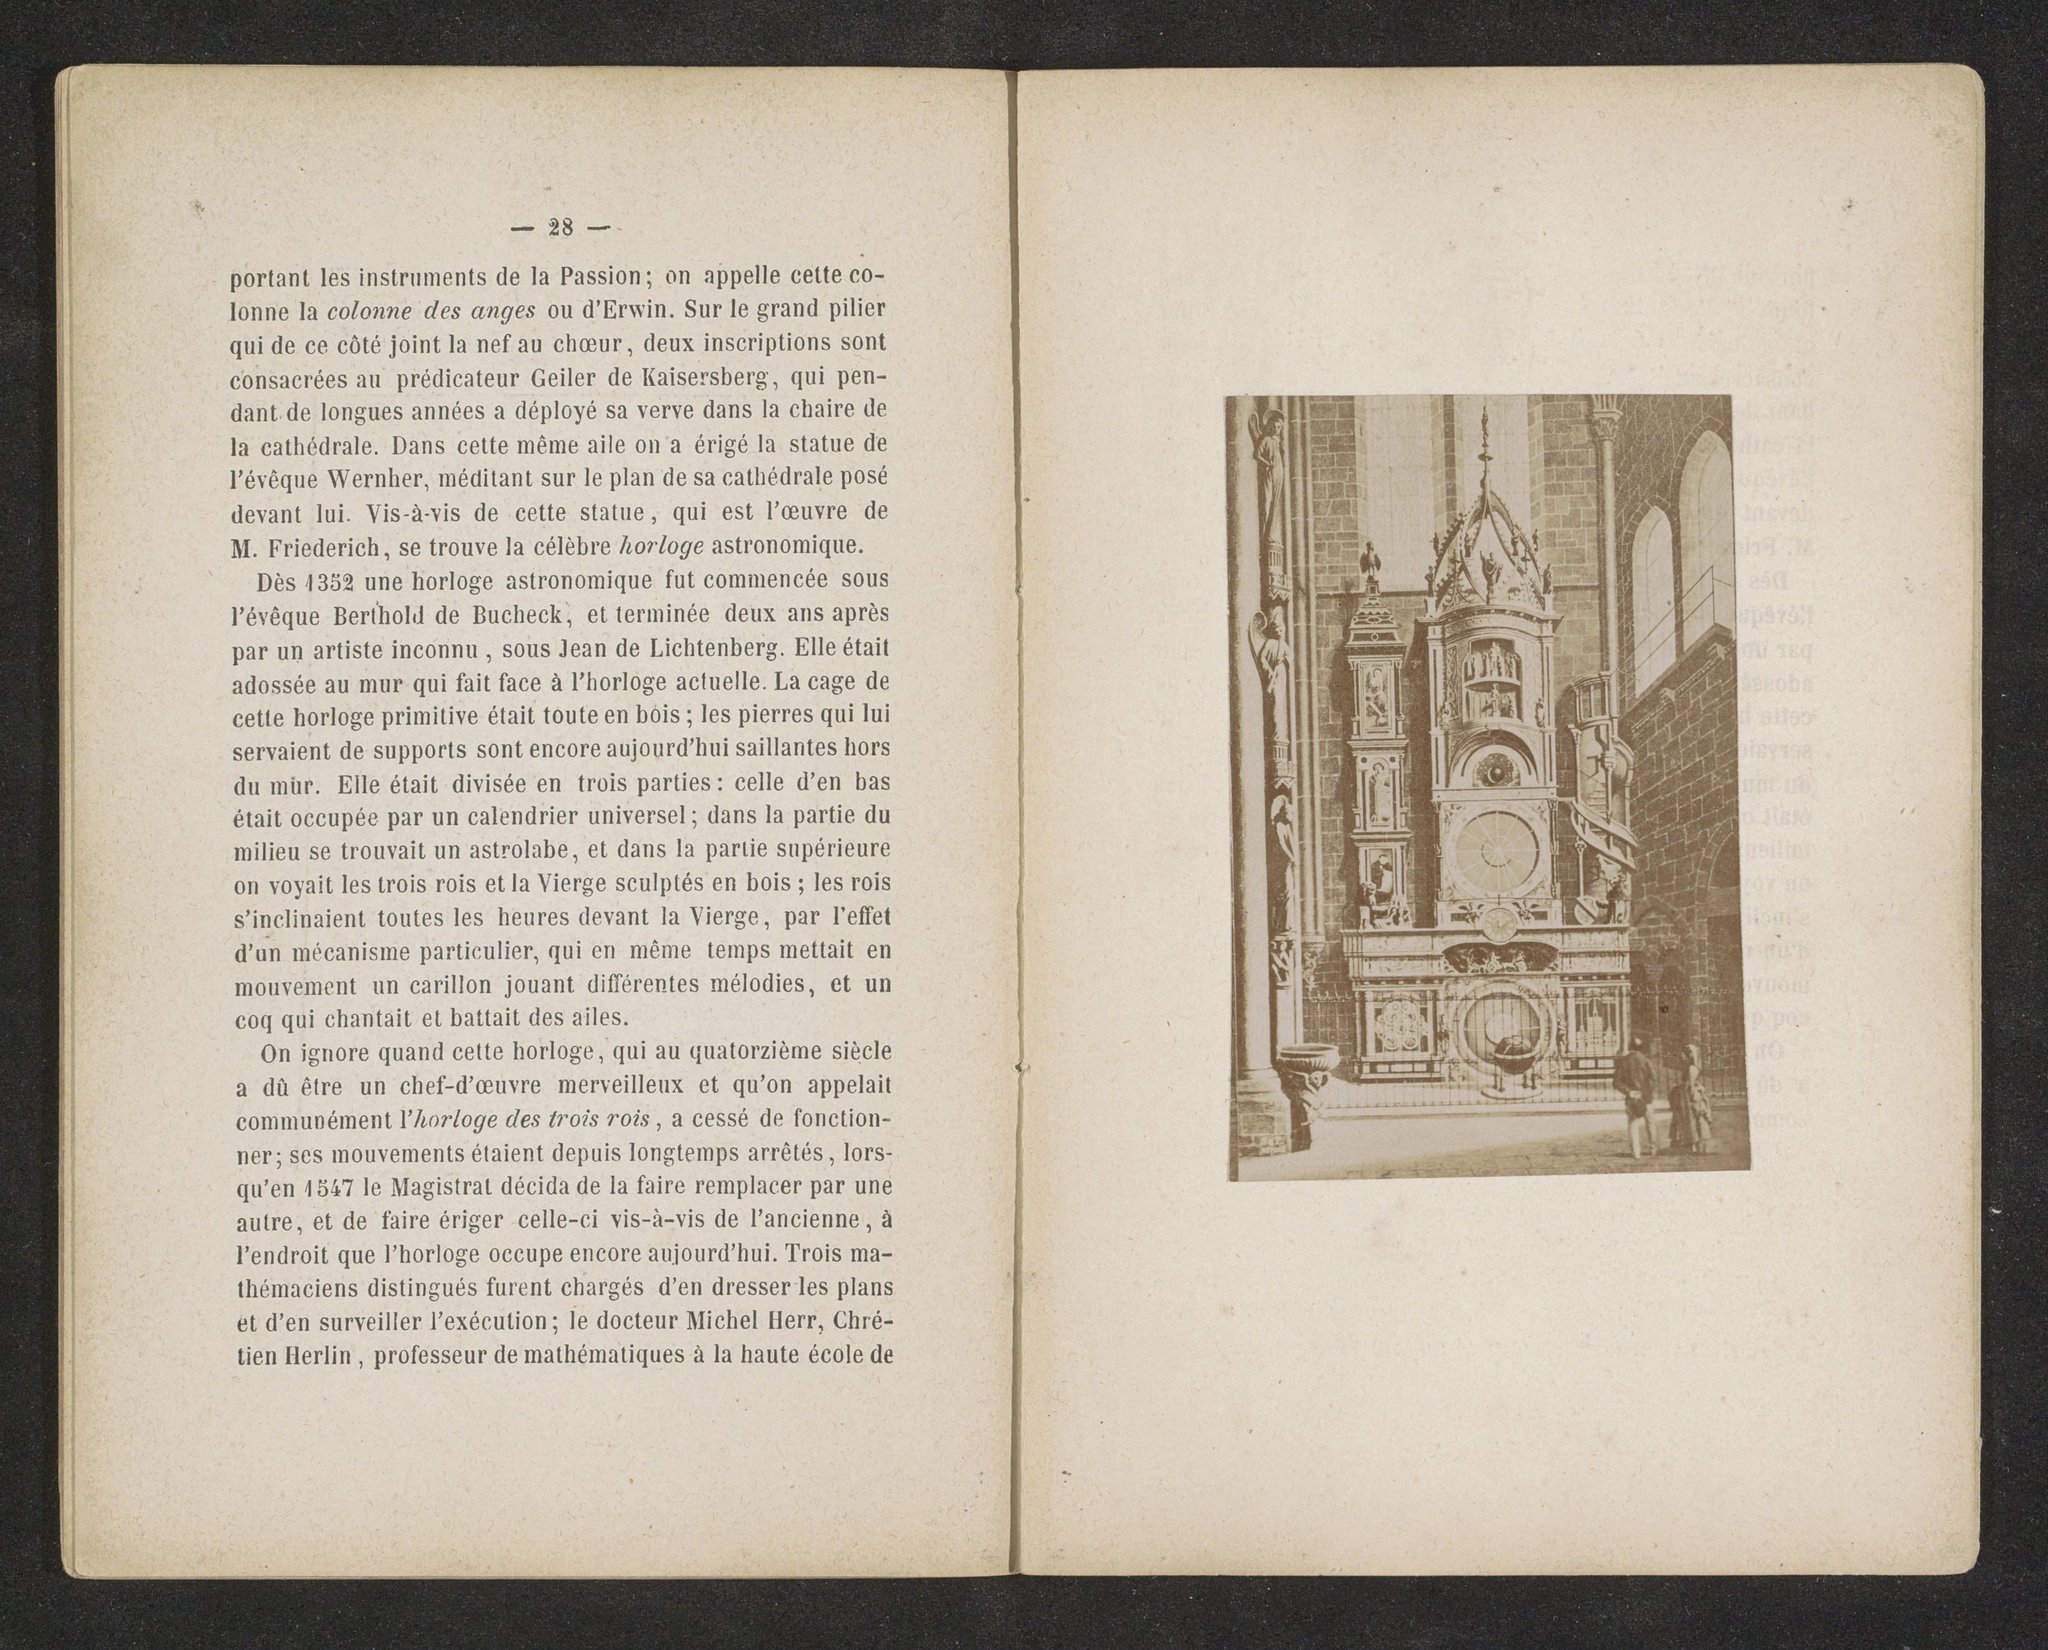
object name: photograph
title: Horloge astronomique in de Notre-Dame van Straatsburg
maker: Anonymous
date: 1876-1886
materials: photographic support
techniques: albumen print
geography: notre-dame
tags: astronomical instruments